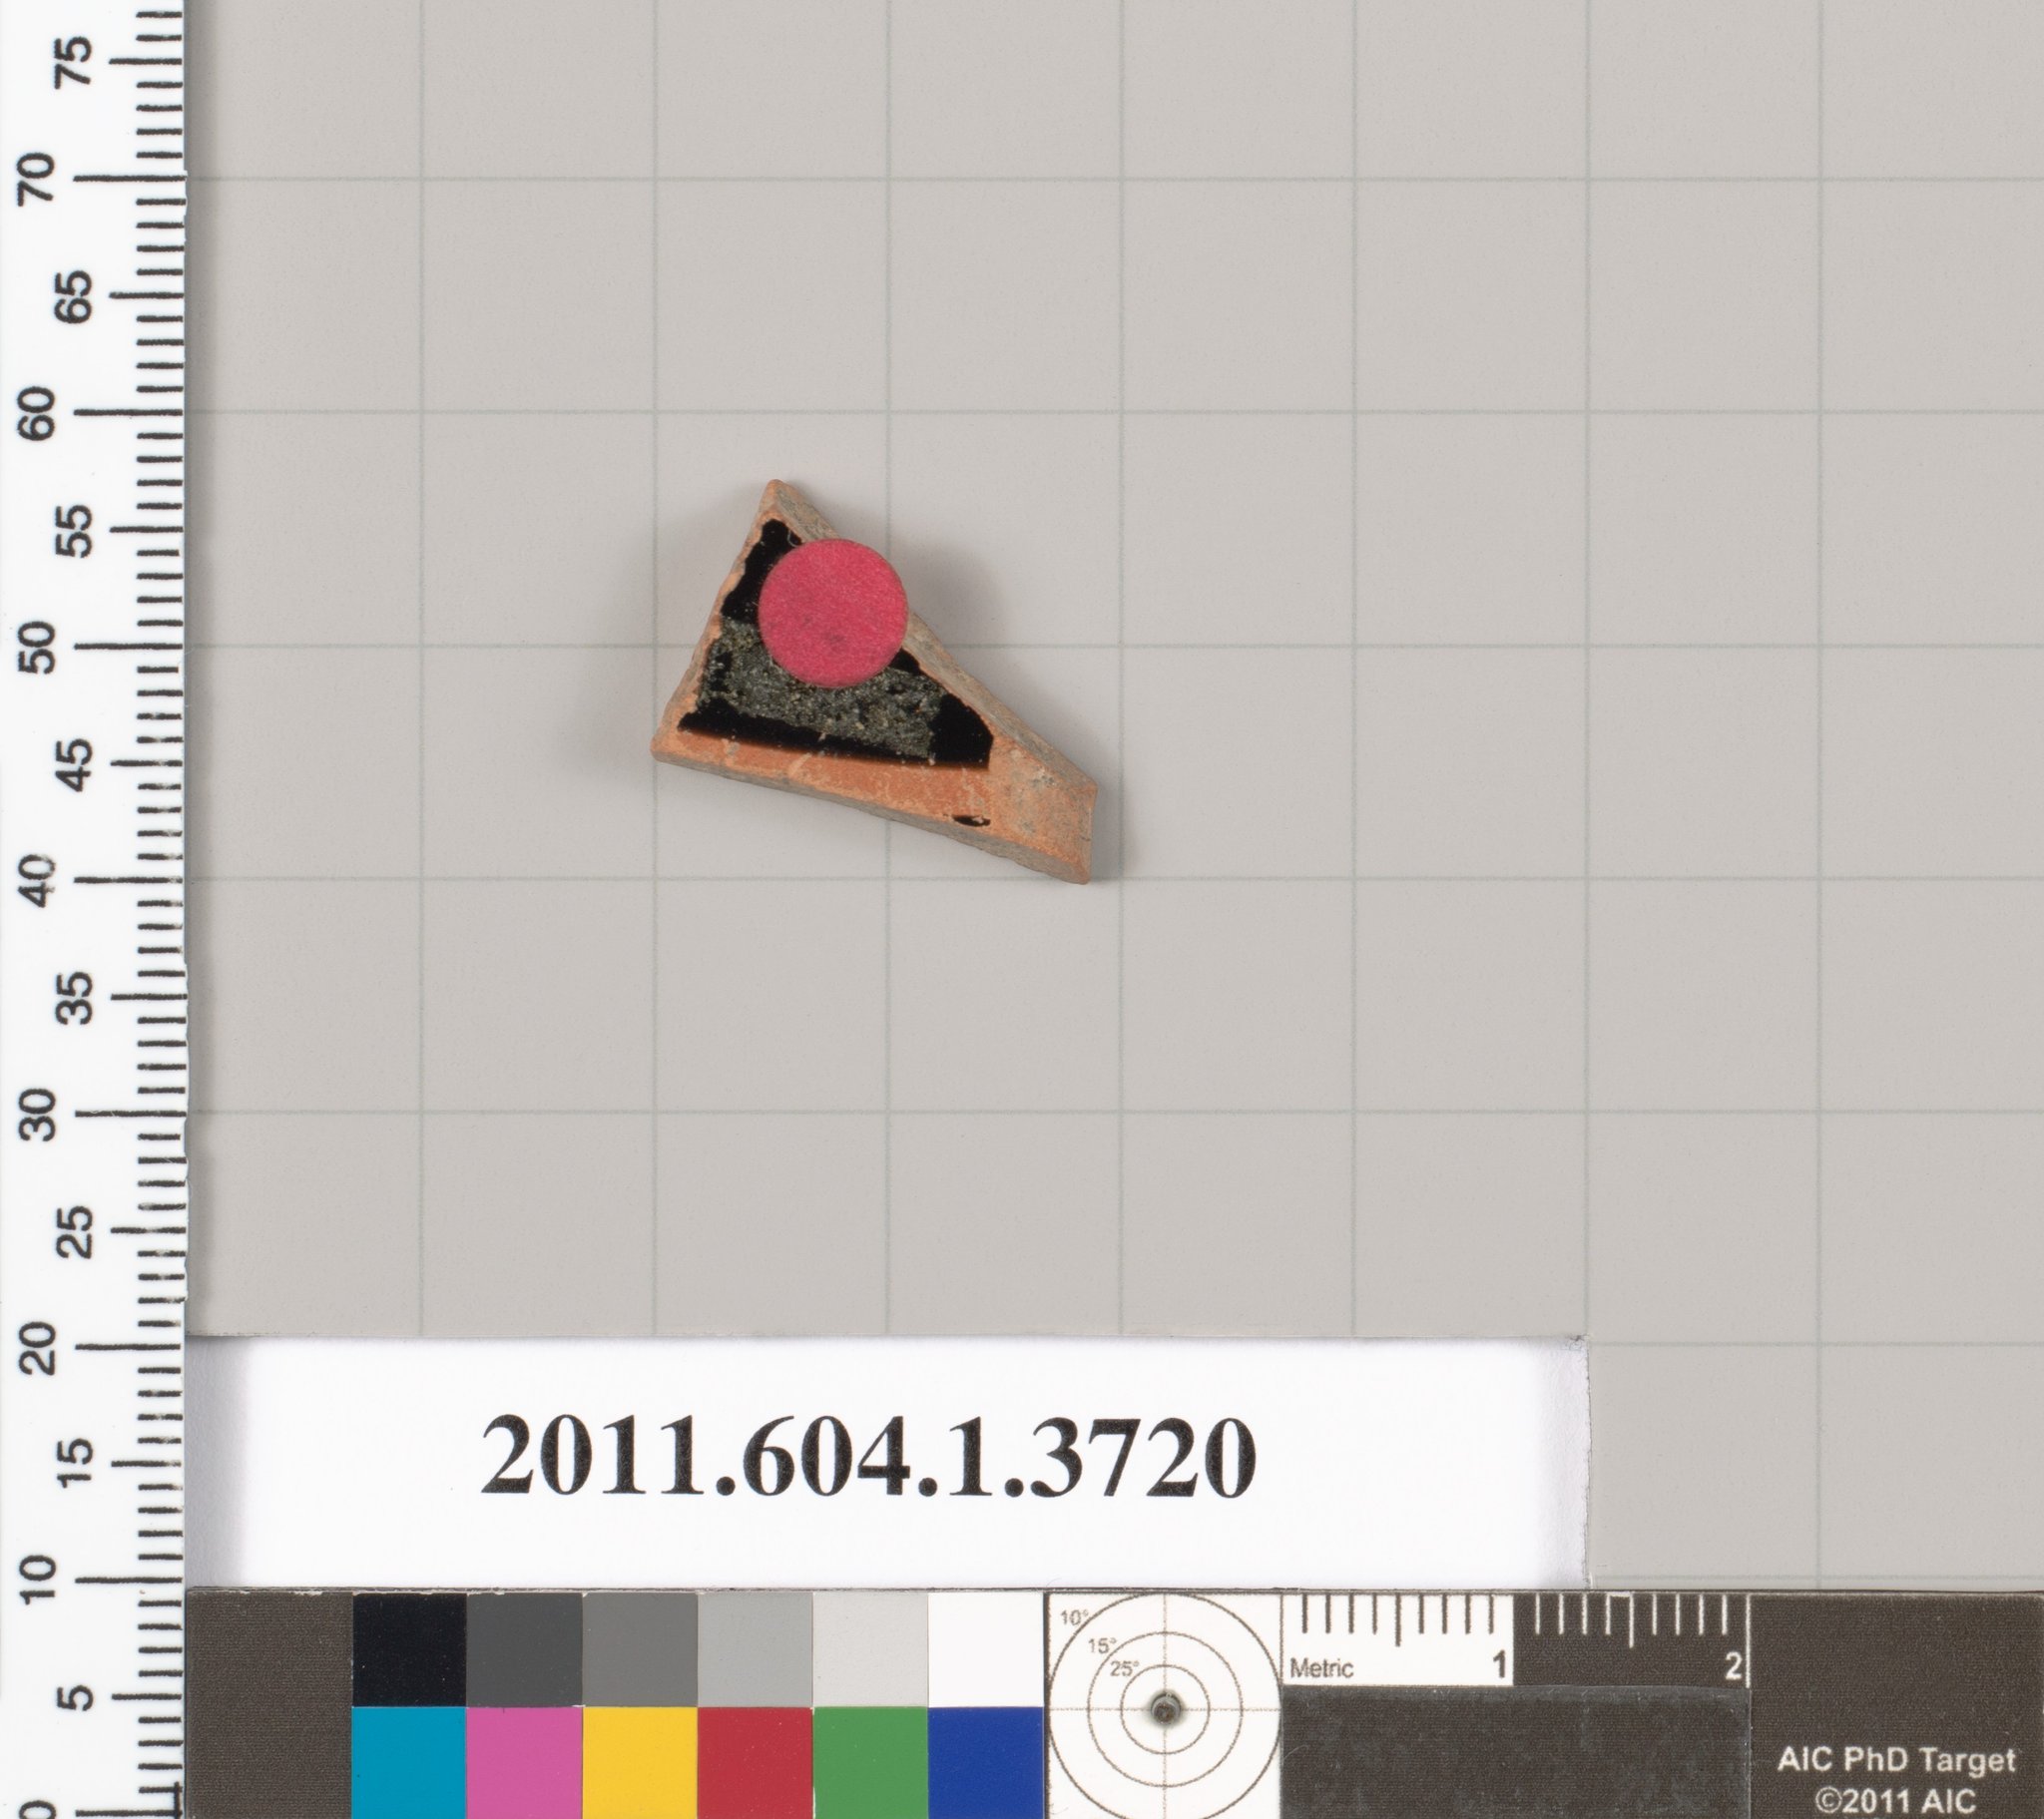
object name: kylix fragment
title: Terracotta fragment of a kylix (drinking cup)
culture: greek, attic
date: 500-470 BCE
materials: terracotta